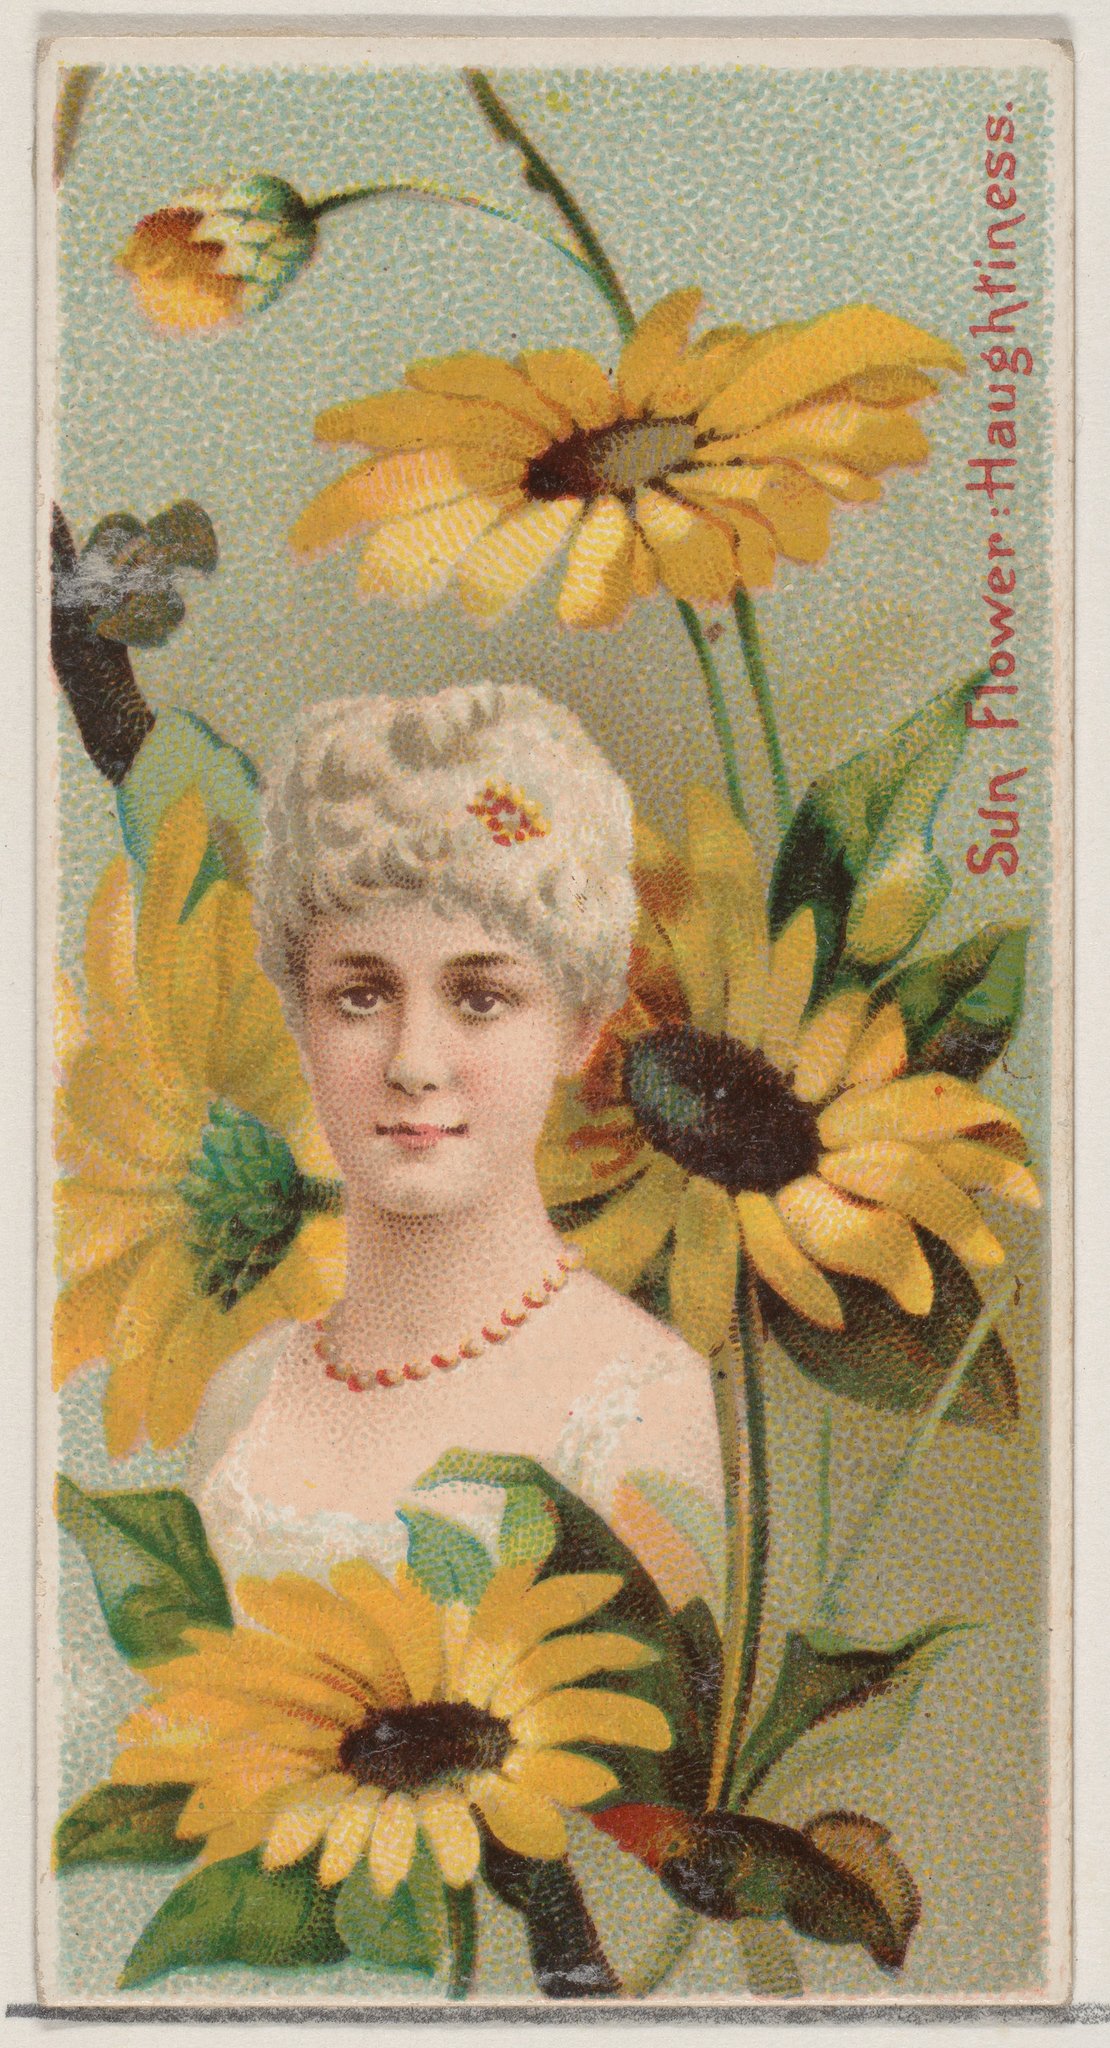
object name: print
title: Sunflower: Haughtiness, from the series Floral Beauties and Language of Flowers (N75) for Duke brand cigarettes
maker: american tobacco company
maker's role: publisher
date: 1892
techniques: color lithograph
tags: women,sunflowers